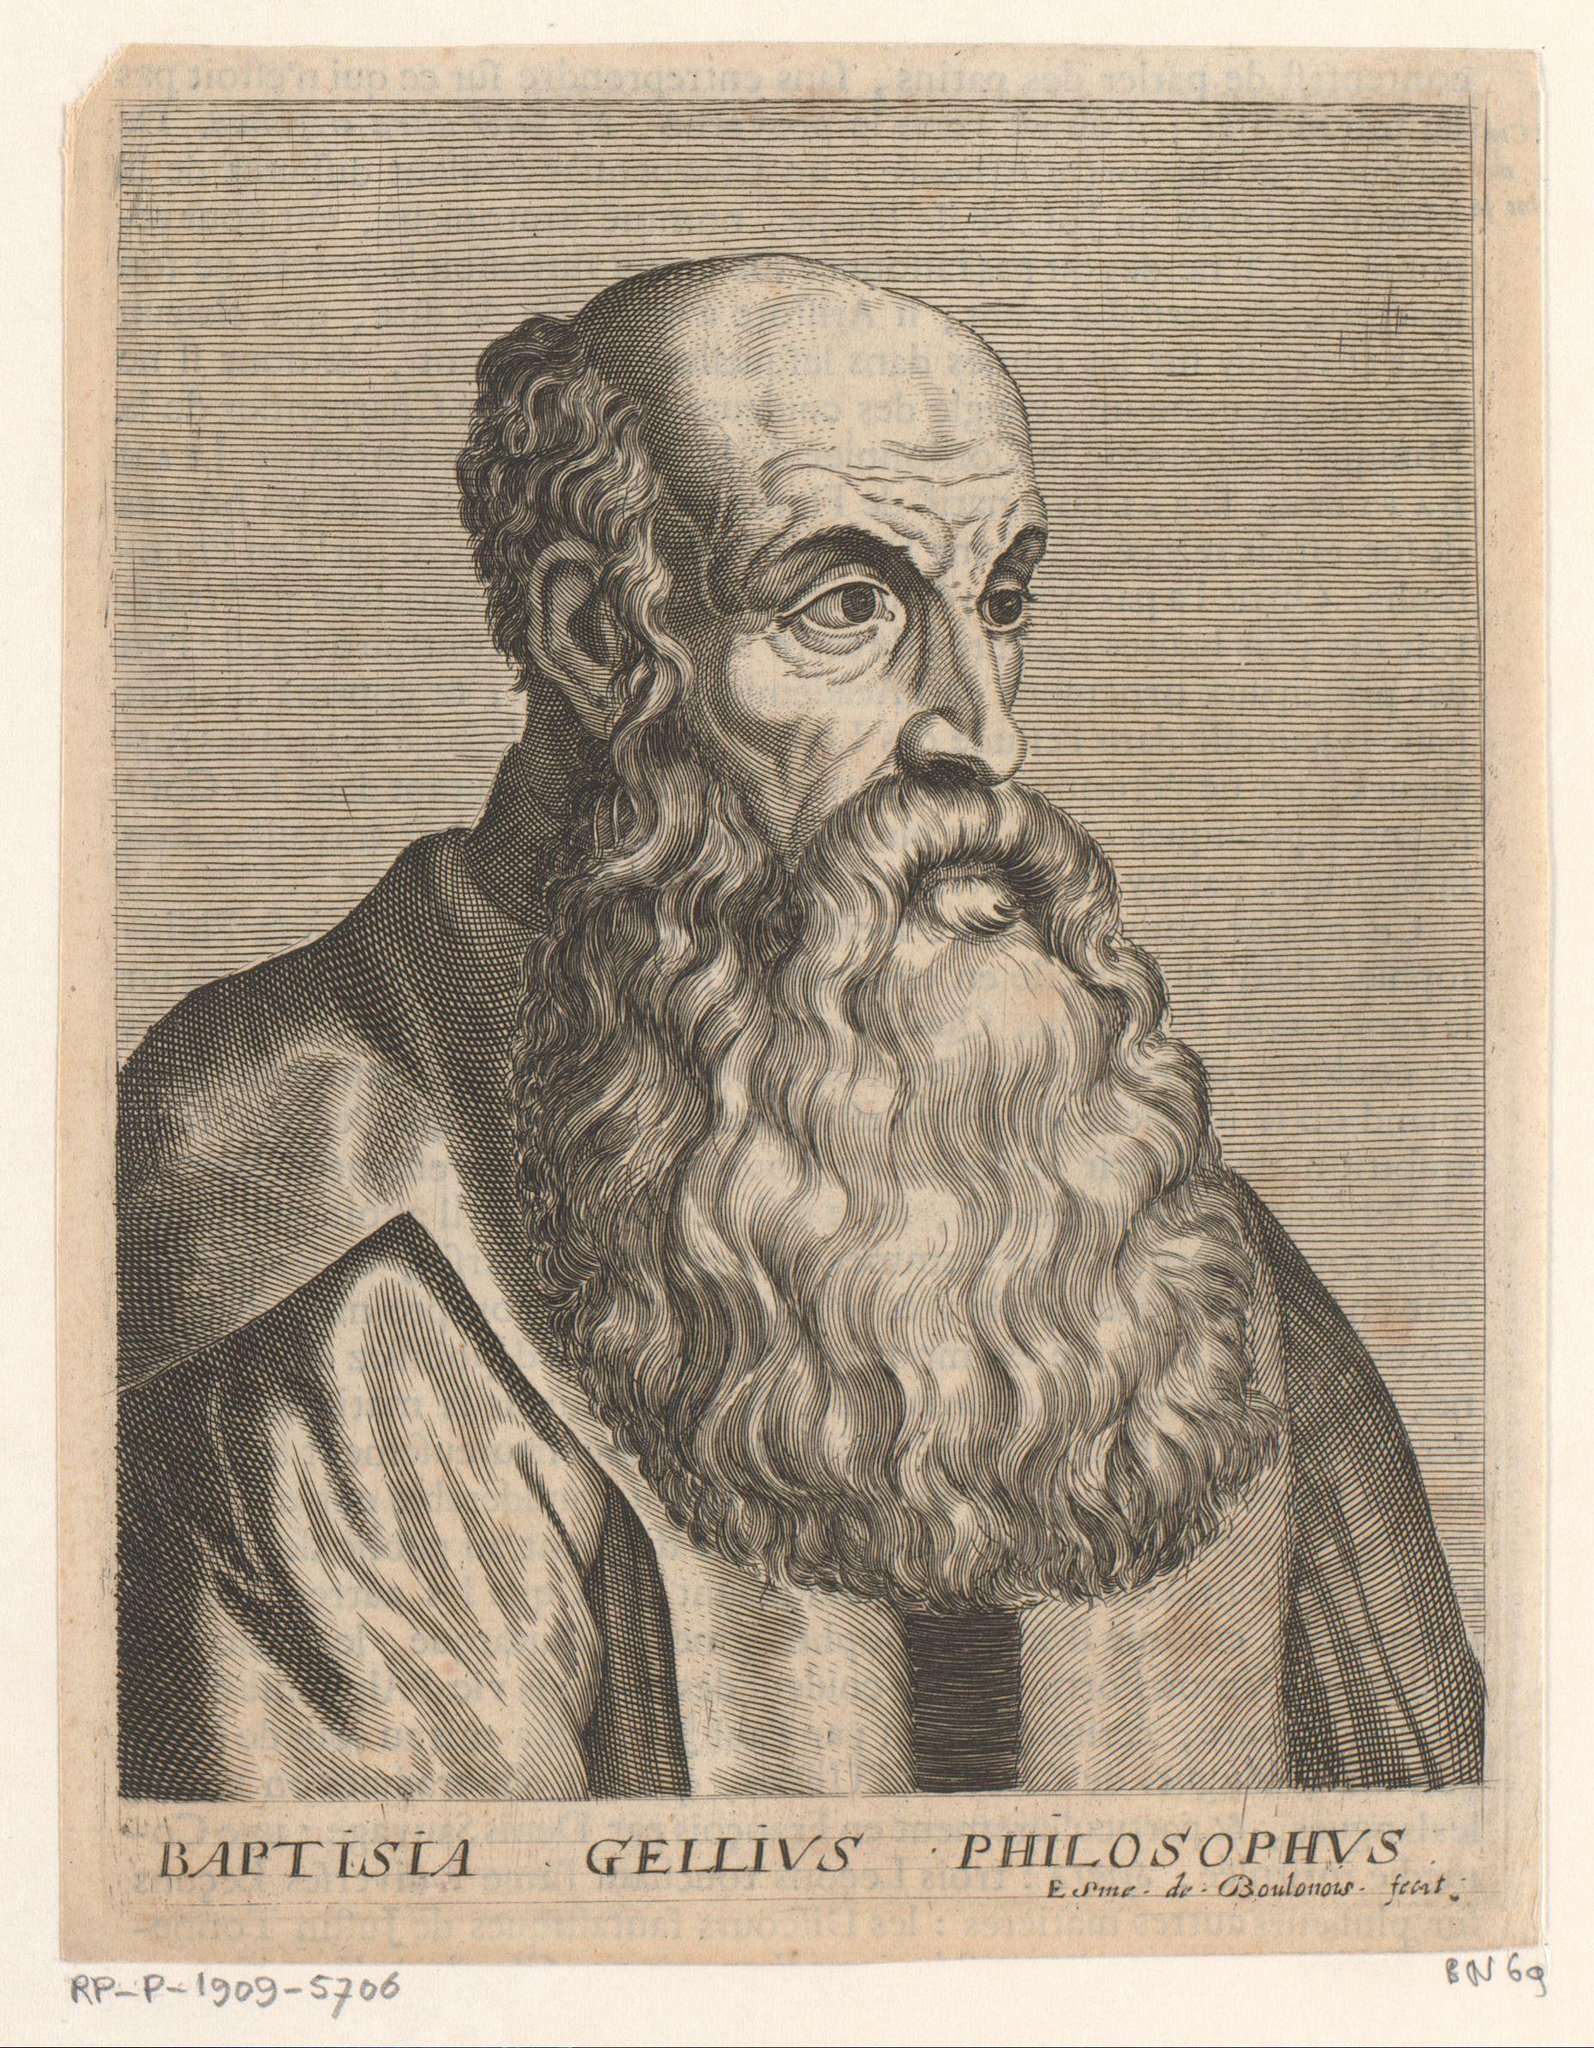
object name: book illustration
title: Baptisia Gellius Philosophus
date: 1682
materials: paper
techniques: engraving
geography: brussels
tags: historical persons, portrait, self-portrait of artist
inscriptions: collector's mark: Lugt 2228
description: Prent uit: Bullert, Isaac. Académie des Sciences et Arts contenant les vies et éloges his. des hommes illustres qui ont excellé en ces professions depuis environ quatre siècles. Brussel: Foppens, François, 1682. Het boek werd in 1682 eveneens in Amsterdam uitgegeven door de erfgenamen van Daniel Elzevier. Deze portretten dienen ter illustratie van de biografie van een kunstenaar of geleerde. De meeste portretten werden door Nicolas de Larmessin vervaardigd (162), 93 door De Boulonois en een derde door ongeïdentificeerde prentmakers. Dit betreft een illustratie op p. 89, deel II.